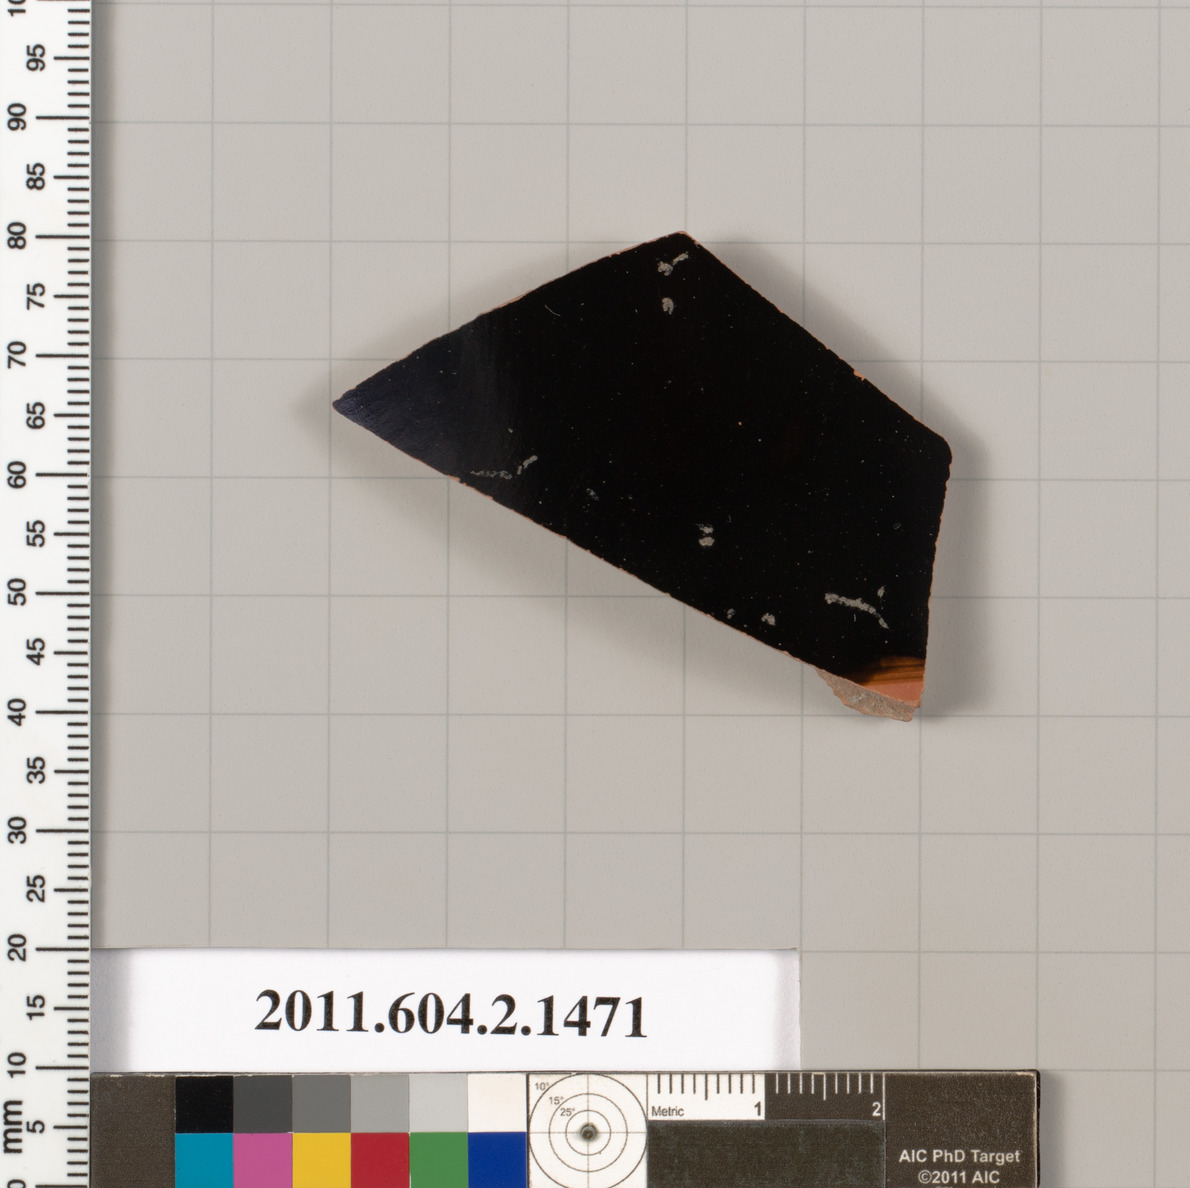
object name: skyphos fragment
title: Terracotta fragment of a skyphos (deep drinking cup)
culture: greek, attic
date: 500-401 BCE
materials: terracotta